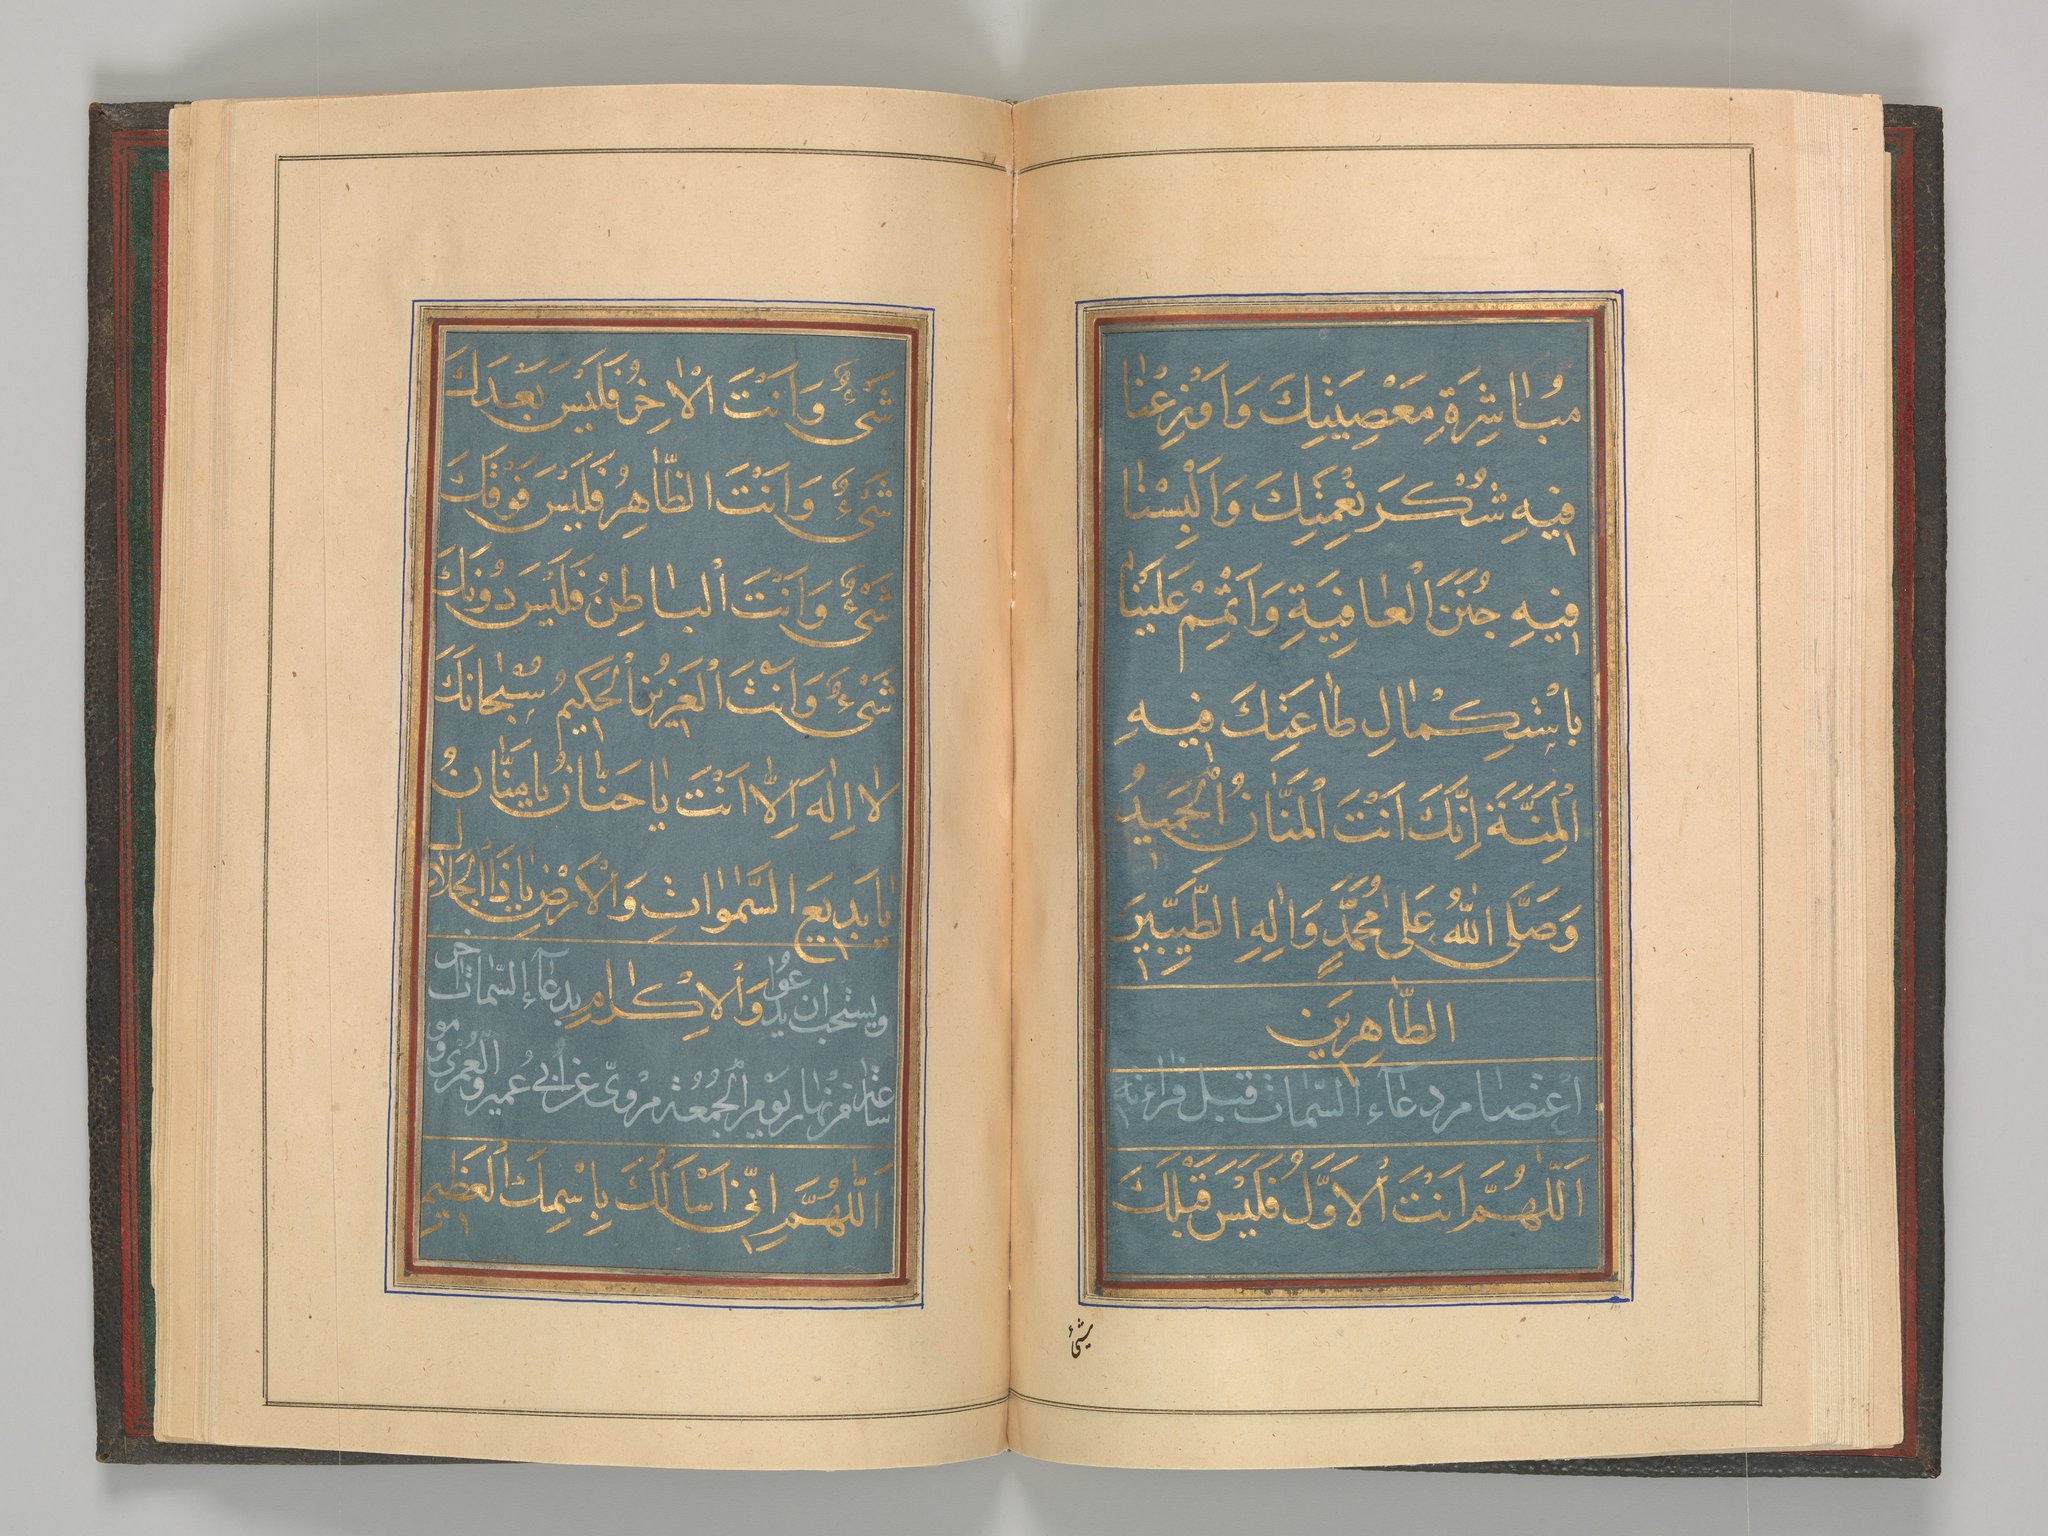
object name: non illustrated manuscript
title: Book of Prayers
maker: muhammad hussein kaziruni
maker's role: calligrapher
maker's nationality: iranian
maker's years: 1675-1725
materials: gold, ink, paper, watercolor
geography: iran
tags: calligraphy